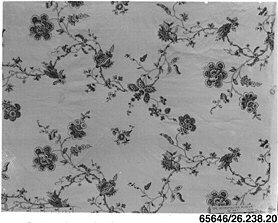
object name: piece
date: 1785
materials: cotton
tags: flowers,leaves